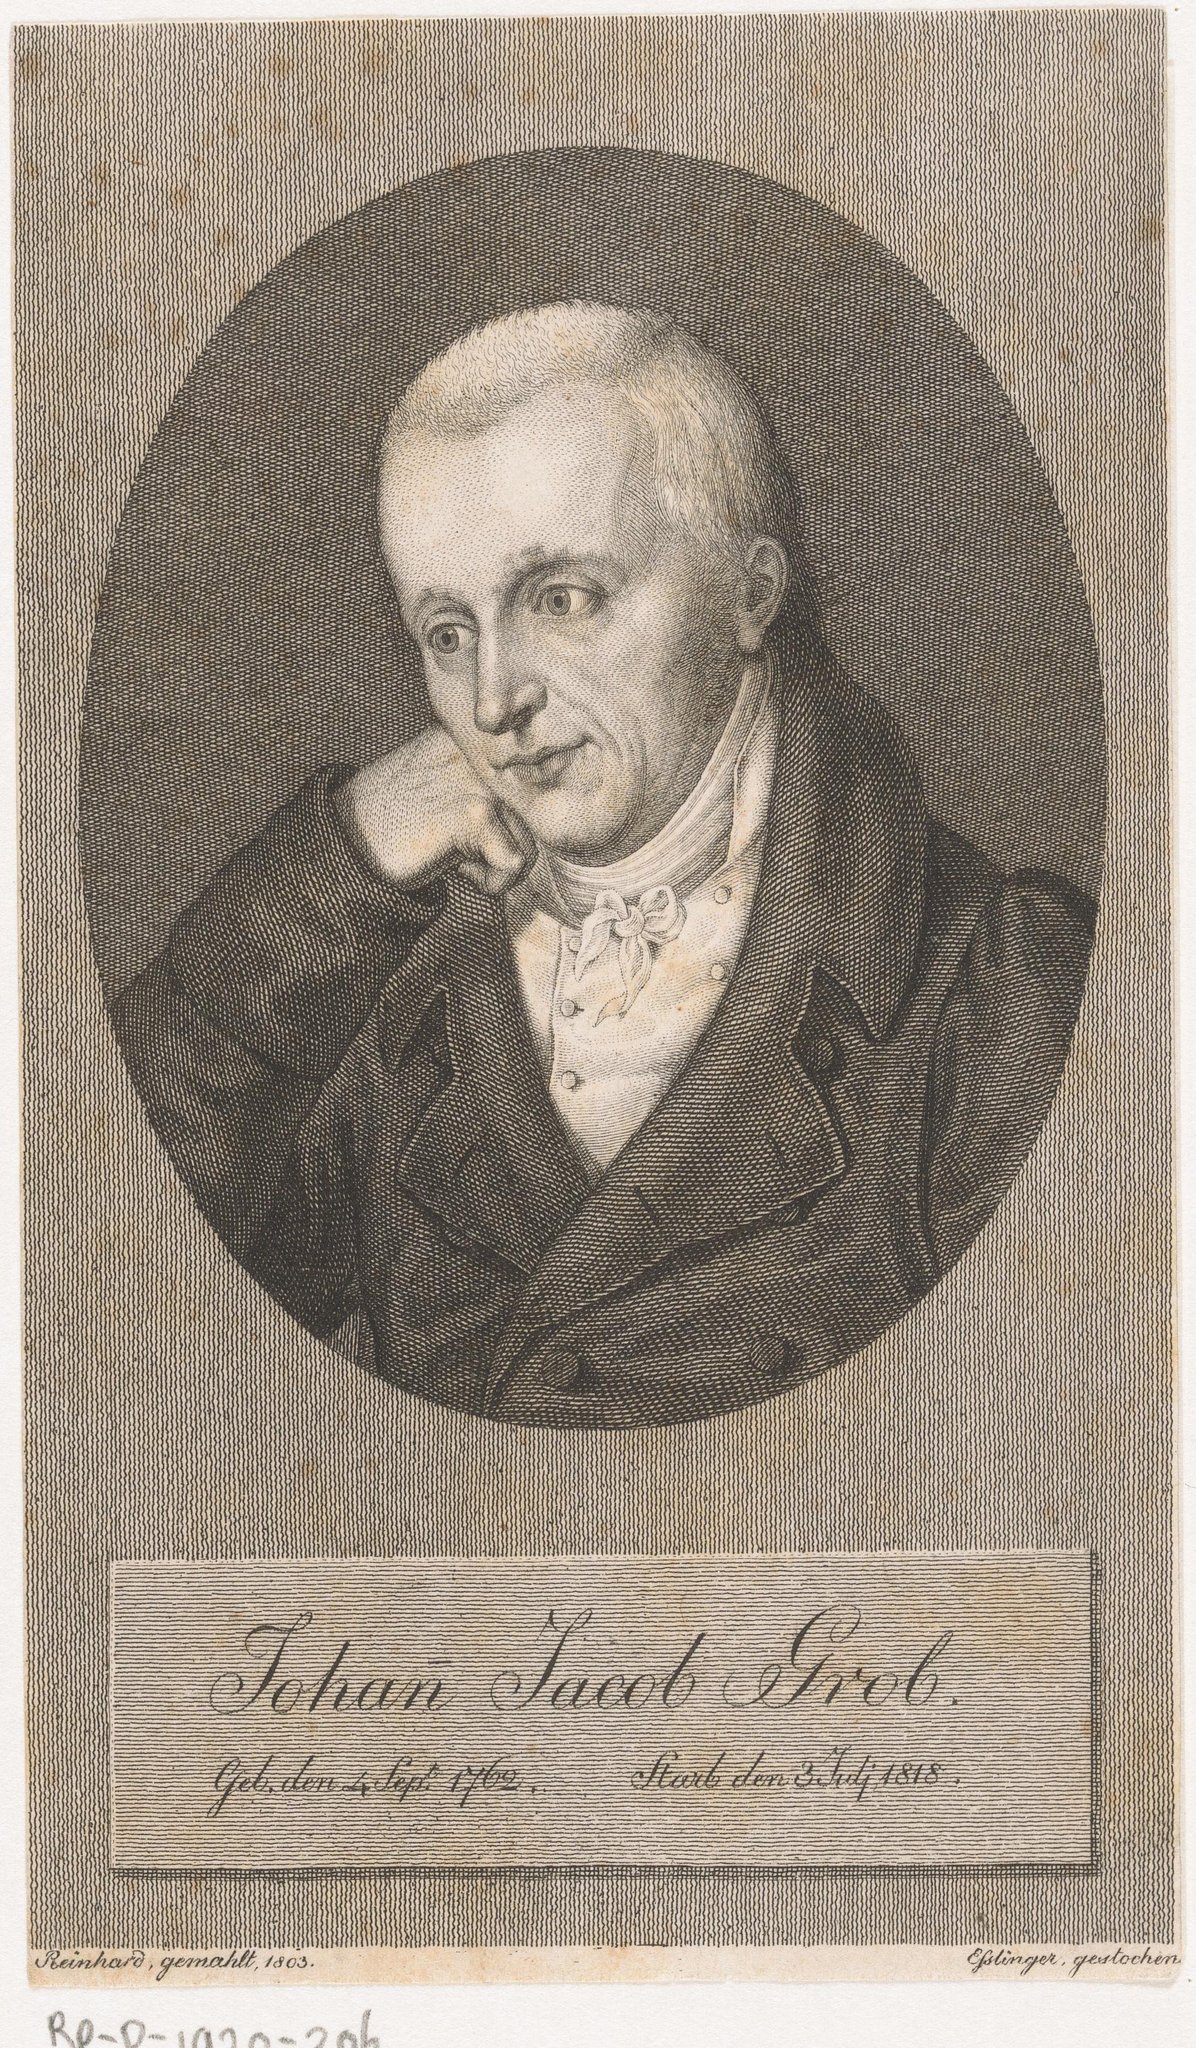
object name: print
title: Portret van Johann Jacob Grob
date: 1803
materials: paper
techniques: engraving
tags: historical persons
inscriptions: collector's mark: Lugt 2228